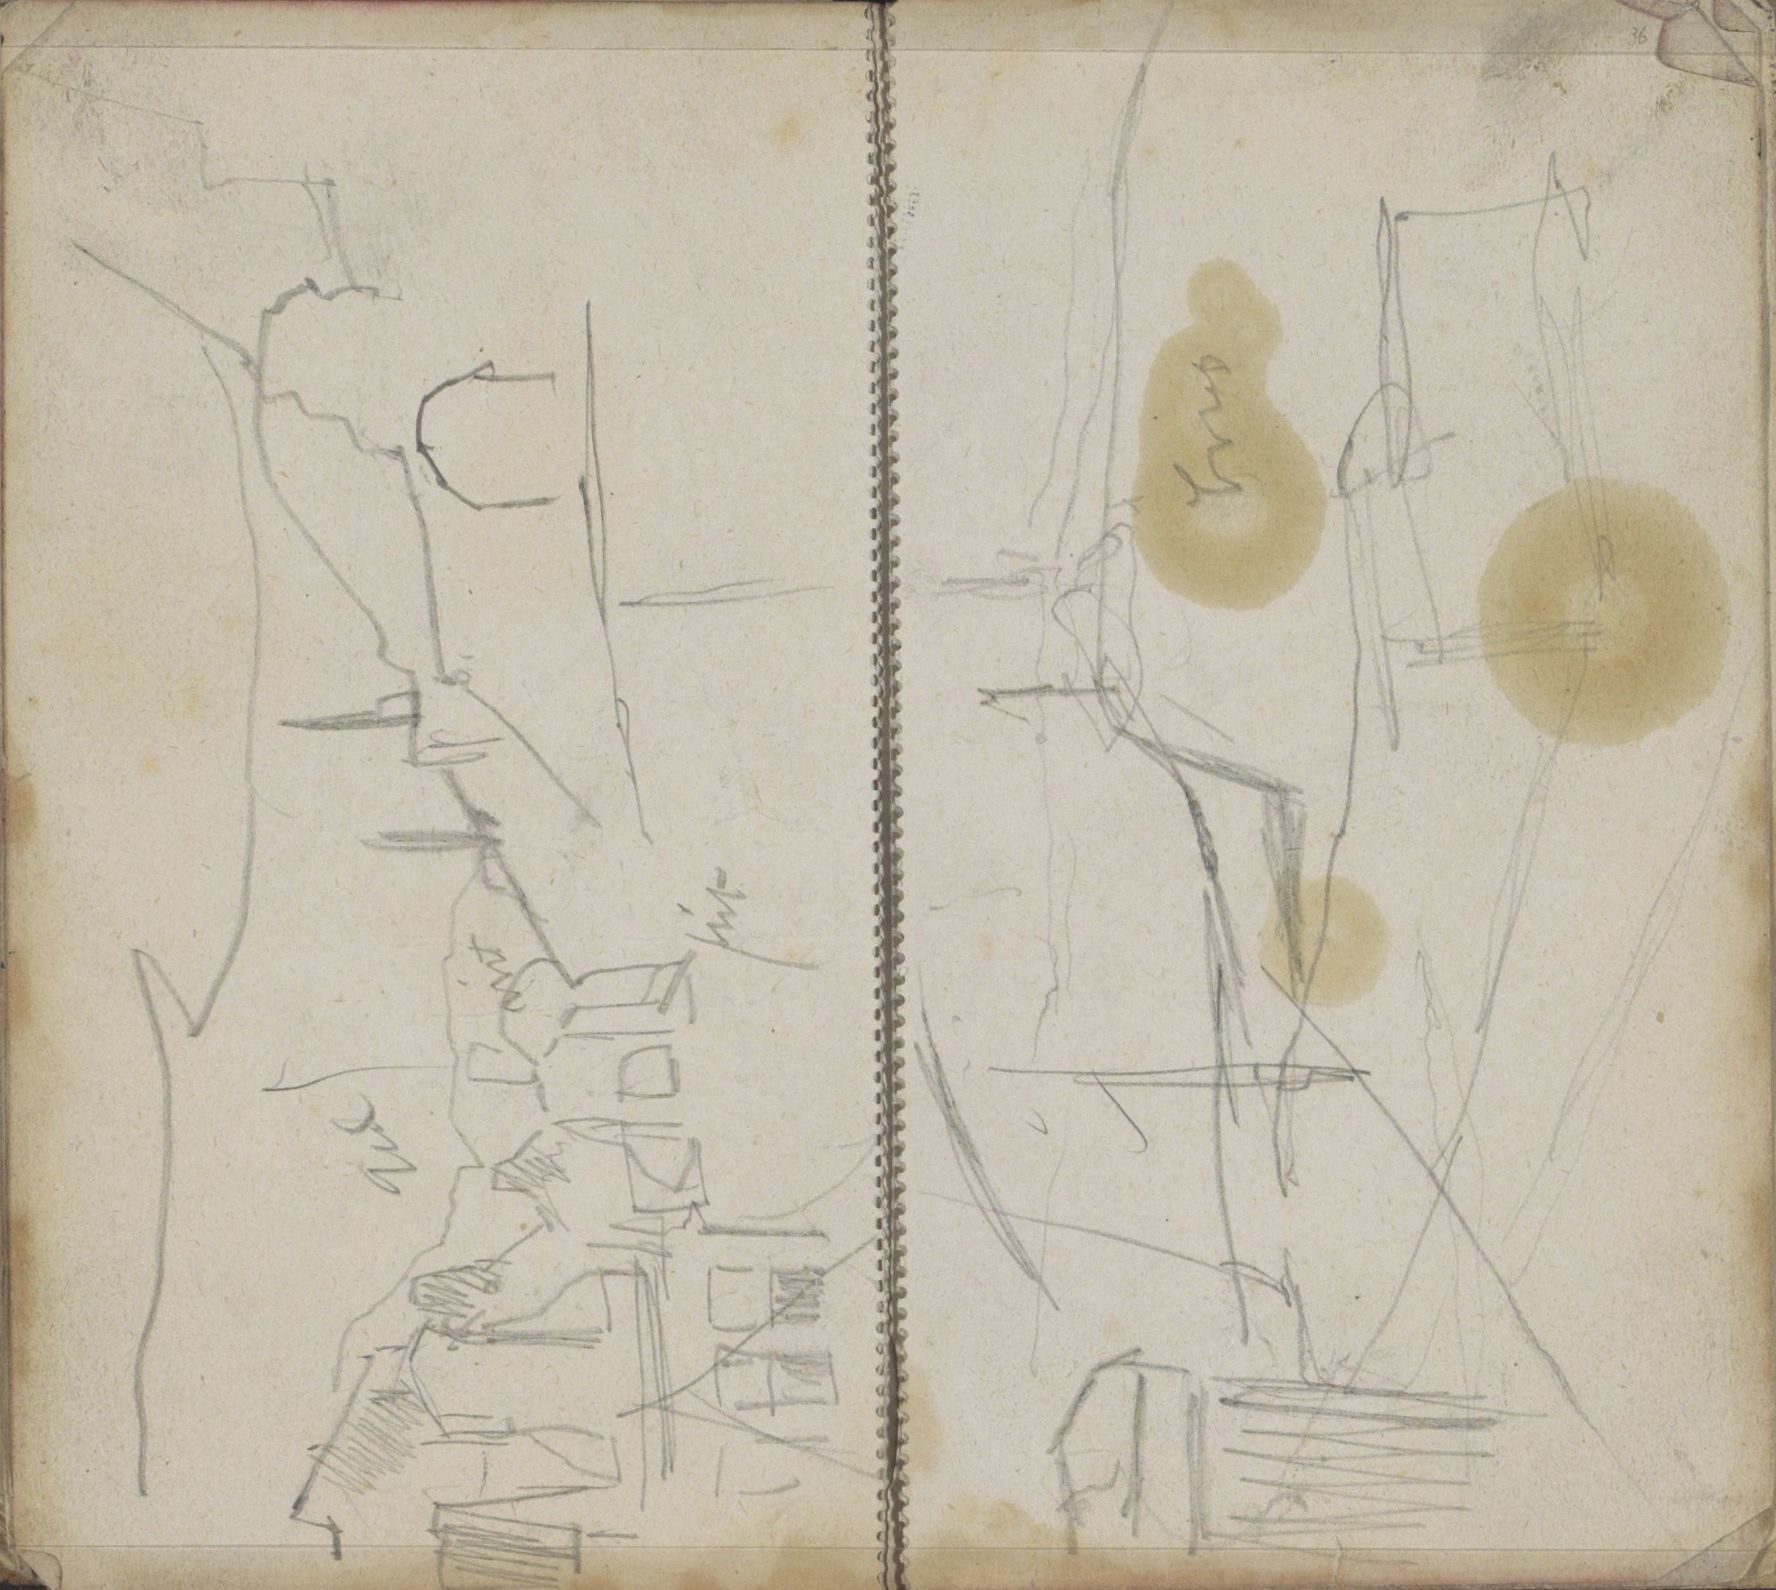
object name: sketchbook leaf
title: Stadsgezicht, mogelijk een gezicht in Amsterdam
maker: george hendrik breitner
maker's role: draughtsman, painter, print maker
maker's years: 1857-1923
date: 1893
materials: paper, pencil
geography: amsterdam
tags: city-view, and landscape with man-made constructions, amsterdam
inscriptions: kleurnotitie, handgeschreven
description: Stadsgezicht, mogelijk een gezicht in Amsterdam. Pagina 35 en pagina 36 uit een schetsboek met 22 bladen vervaardigd te Amsterdam.